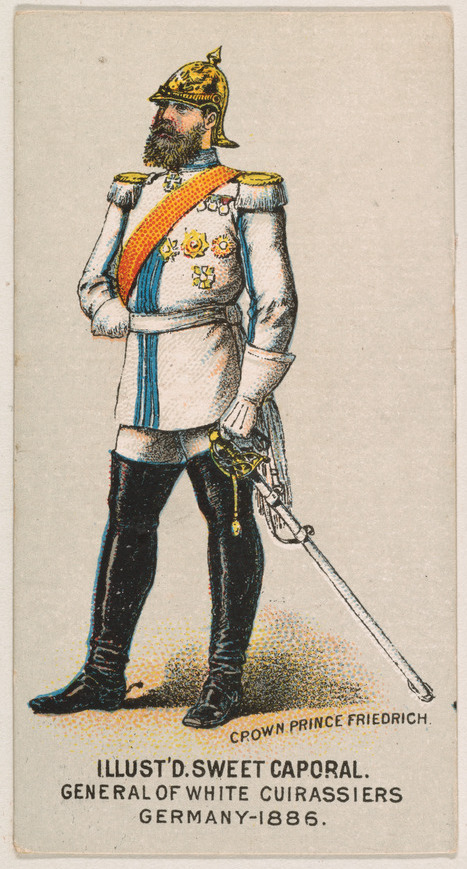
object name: print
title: General, White Cuirassiers, Germany, 1886, from the Military Series (N224) issued by Kinney Tobacco Company to promote Sweet Caporal Cigarettes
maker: kinney brothers tobacco company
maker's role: publisher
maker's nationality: american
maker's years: 1869-2011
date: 1888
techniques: color lithograph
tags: military,soldiers,swords,men